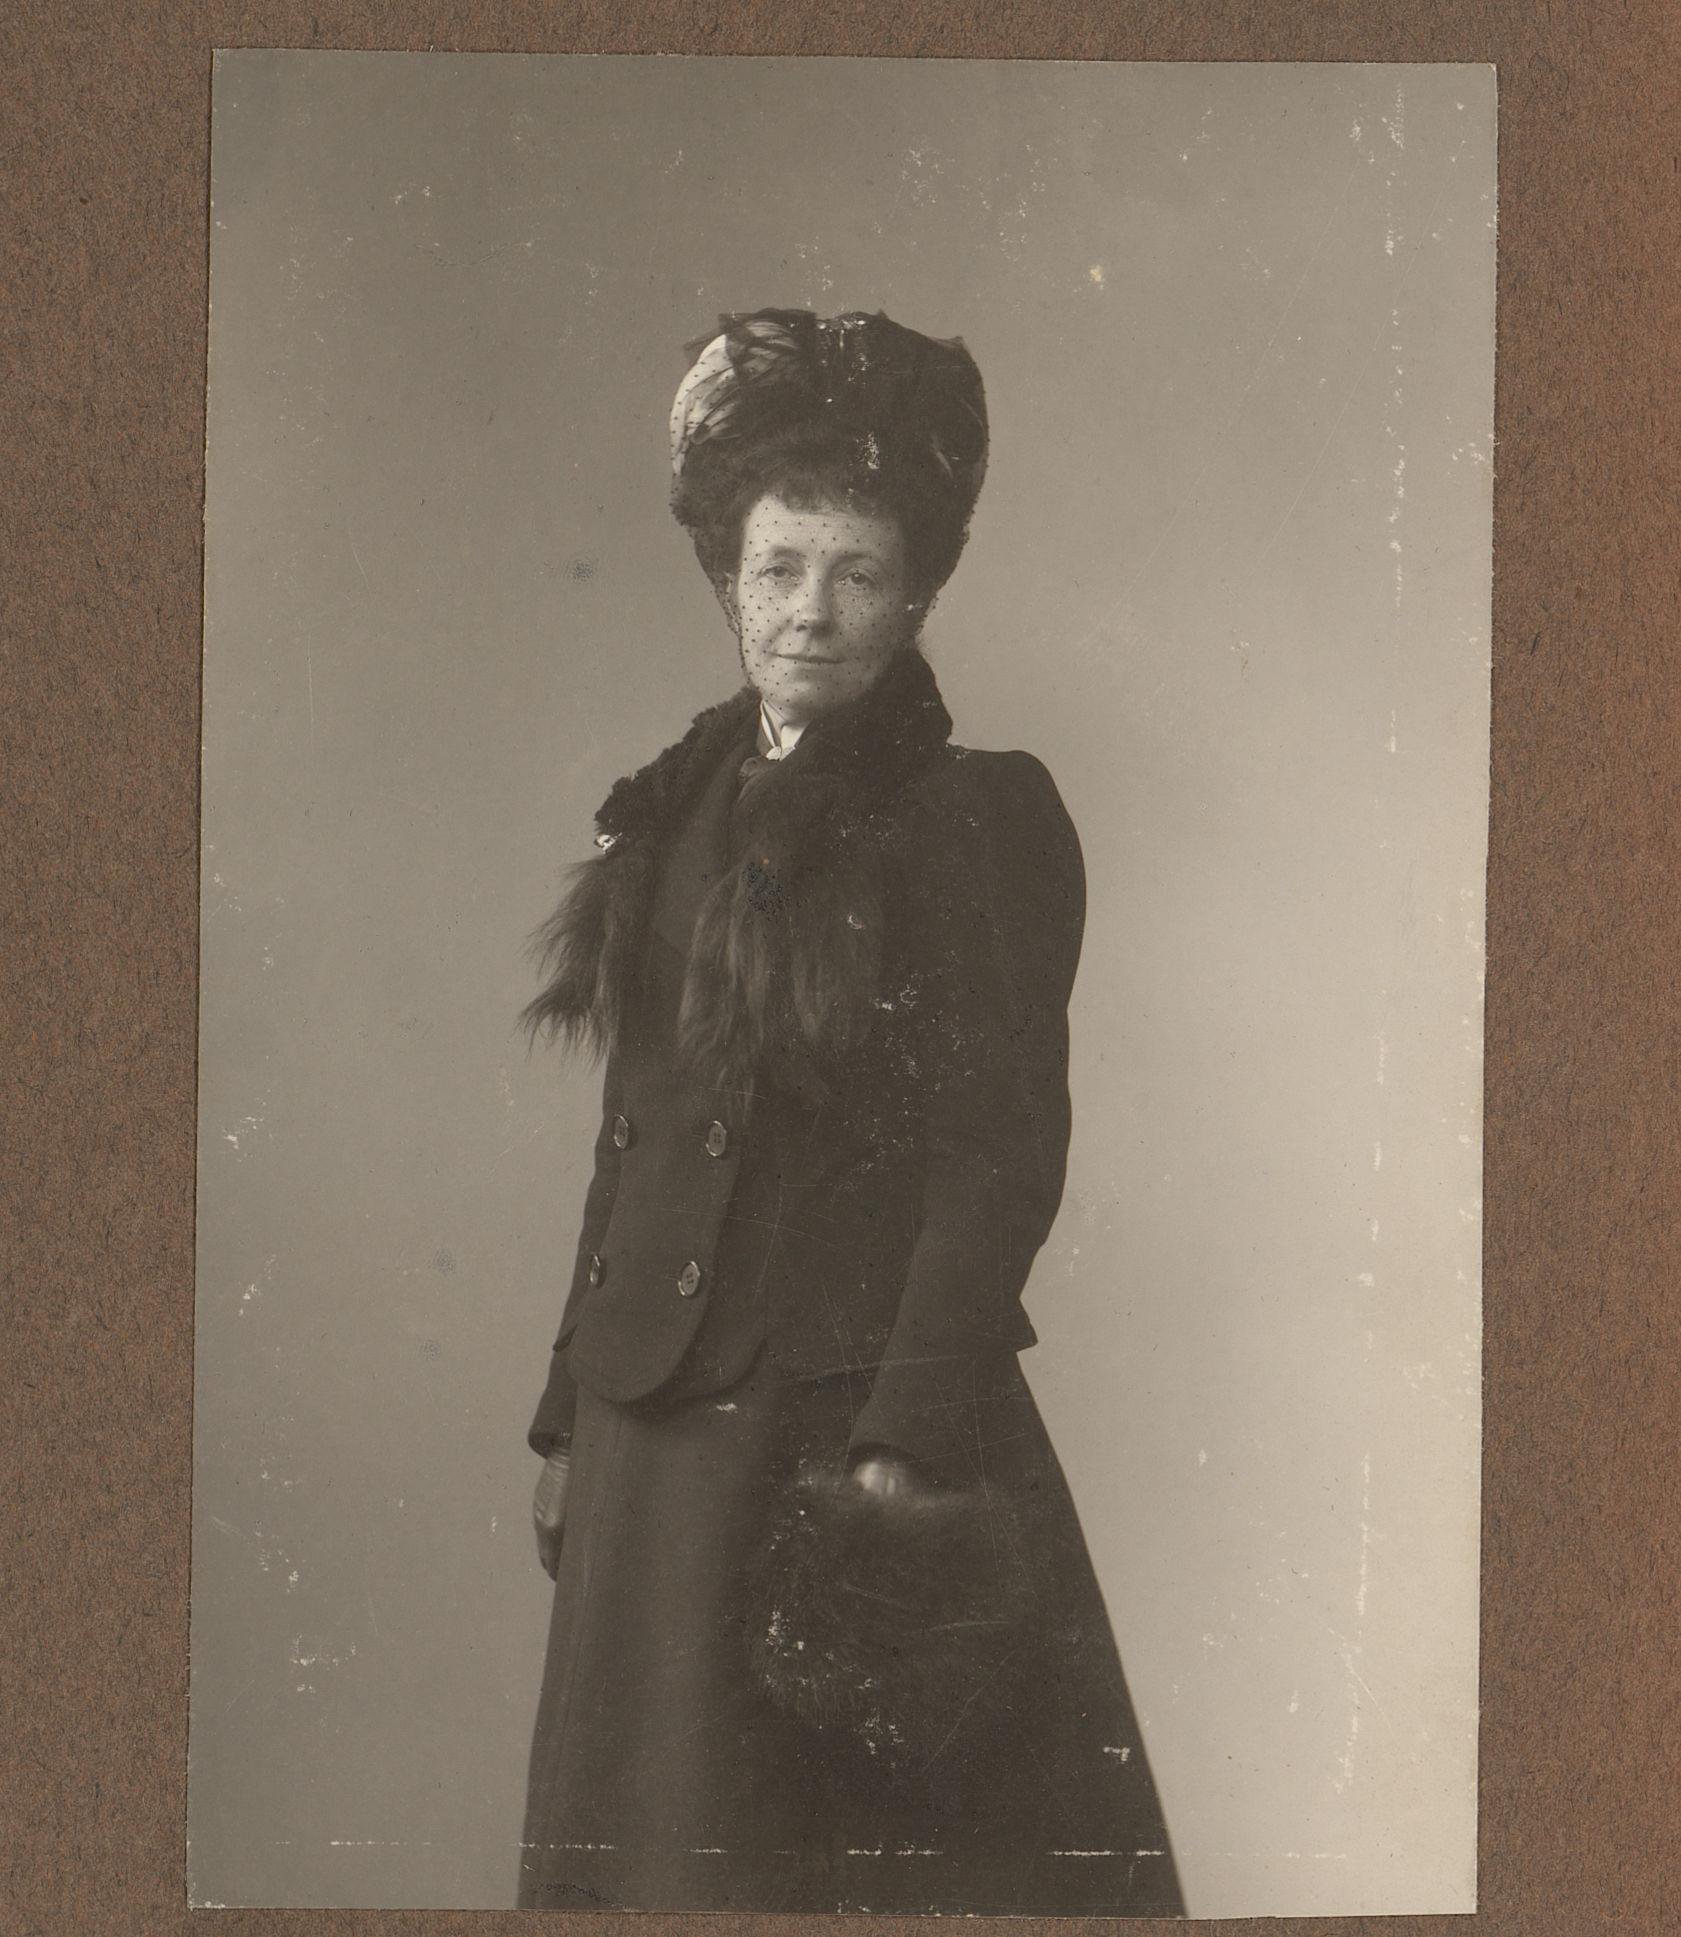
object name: photograph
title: Portret van vrouw met hoofddeksel en mof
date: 1870-1920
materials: photographic support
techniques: photography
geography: amsterdam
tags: netherlands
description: Foto op bruin albumblad 33 van familiealbum van Alphons Diepenbrock.